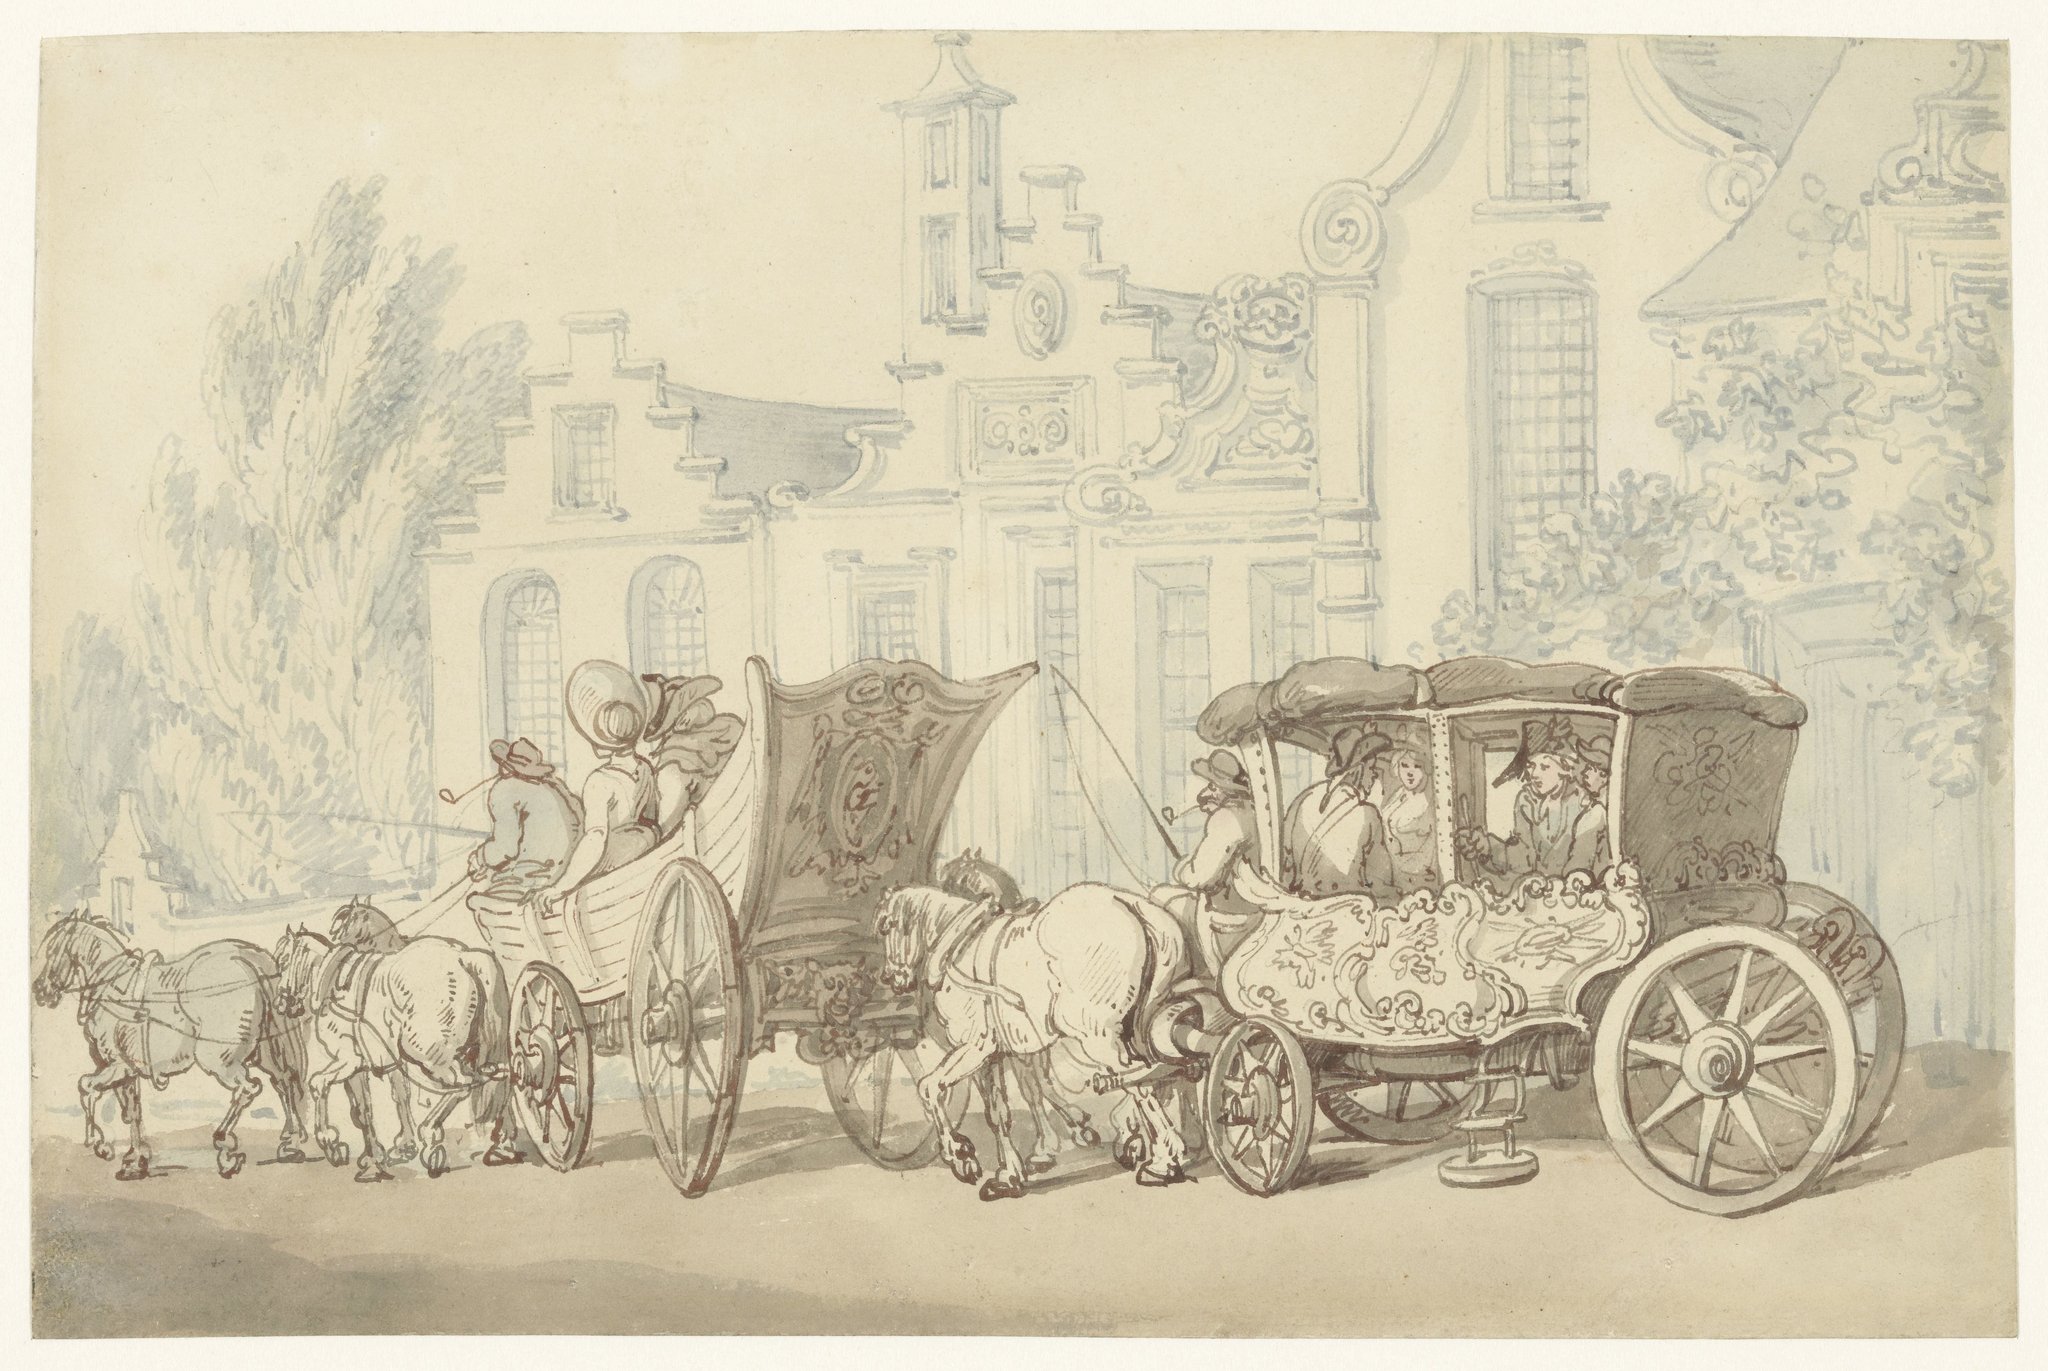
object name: drawing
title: Open reiswagen en koets in een quasi-Hollandse straat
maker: thomas rowlandson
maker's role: draughtsman, print maker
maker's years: 1756-1827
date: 1790-1827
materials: chalk, ink, paper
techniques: brush, pen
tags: four-wheeled, animal-drawn vehicle, e.g.: cab, carriage, coach